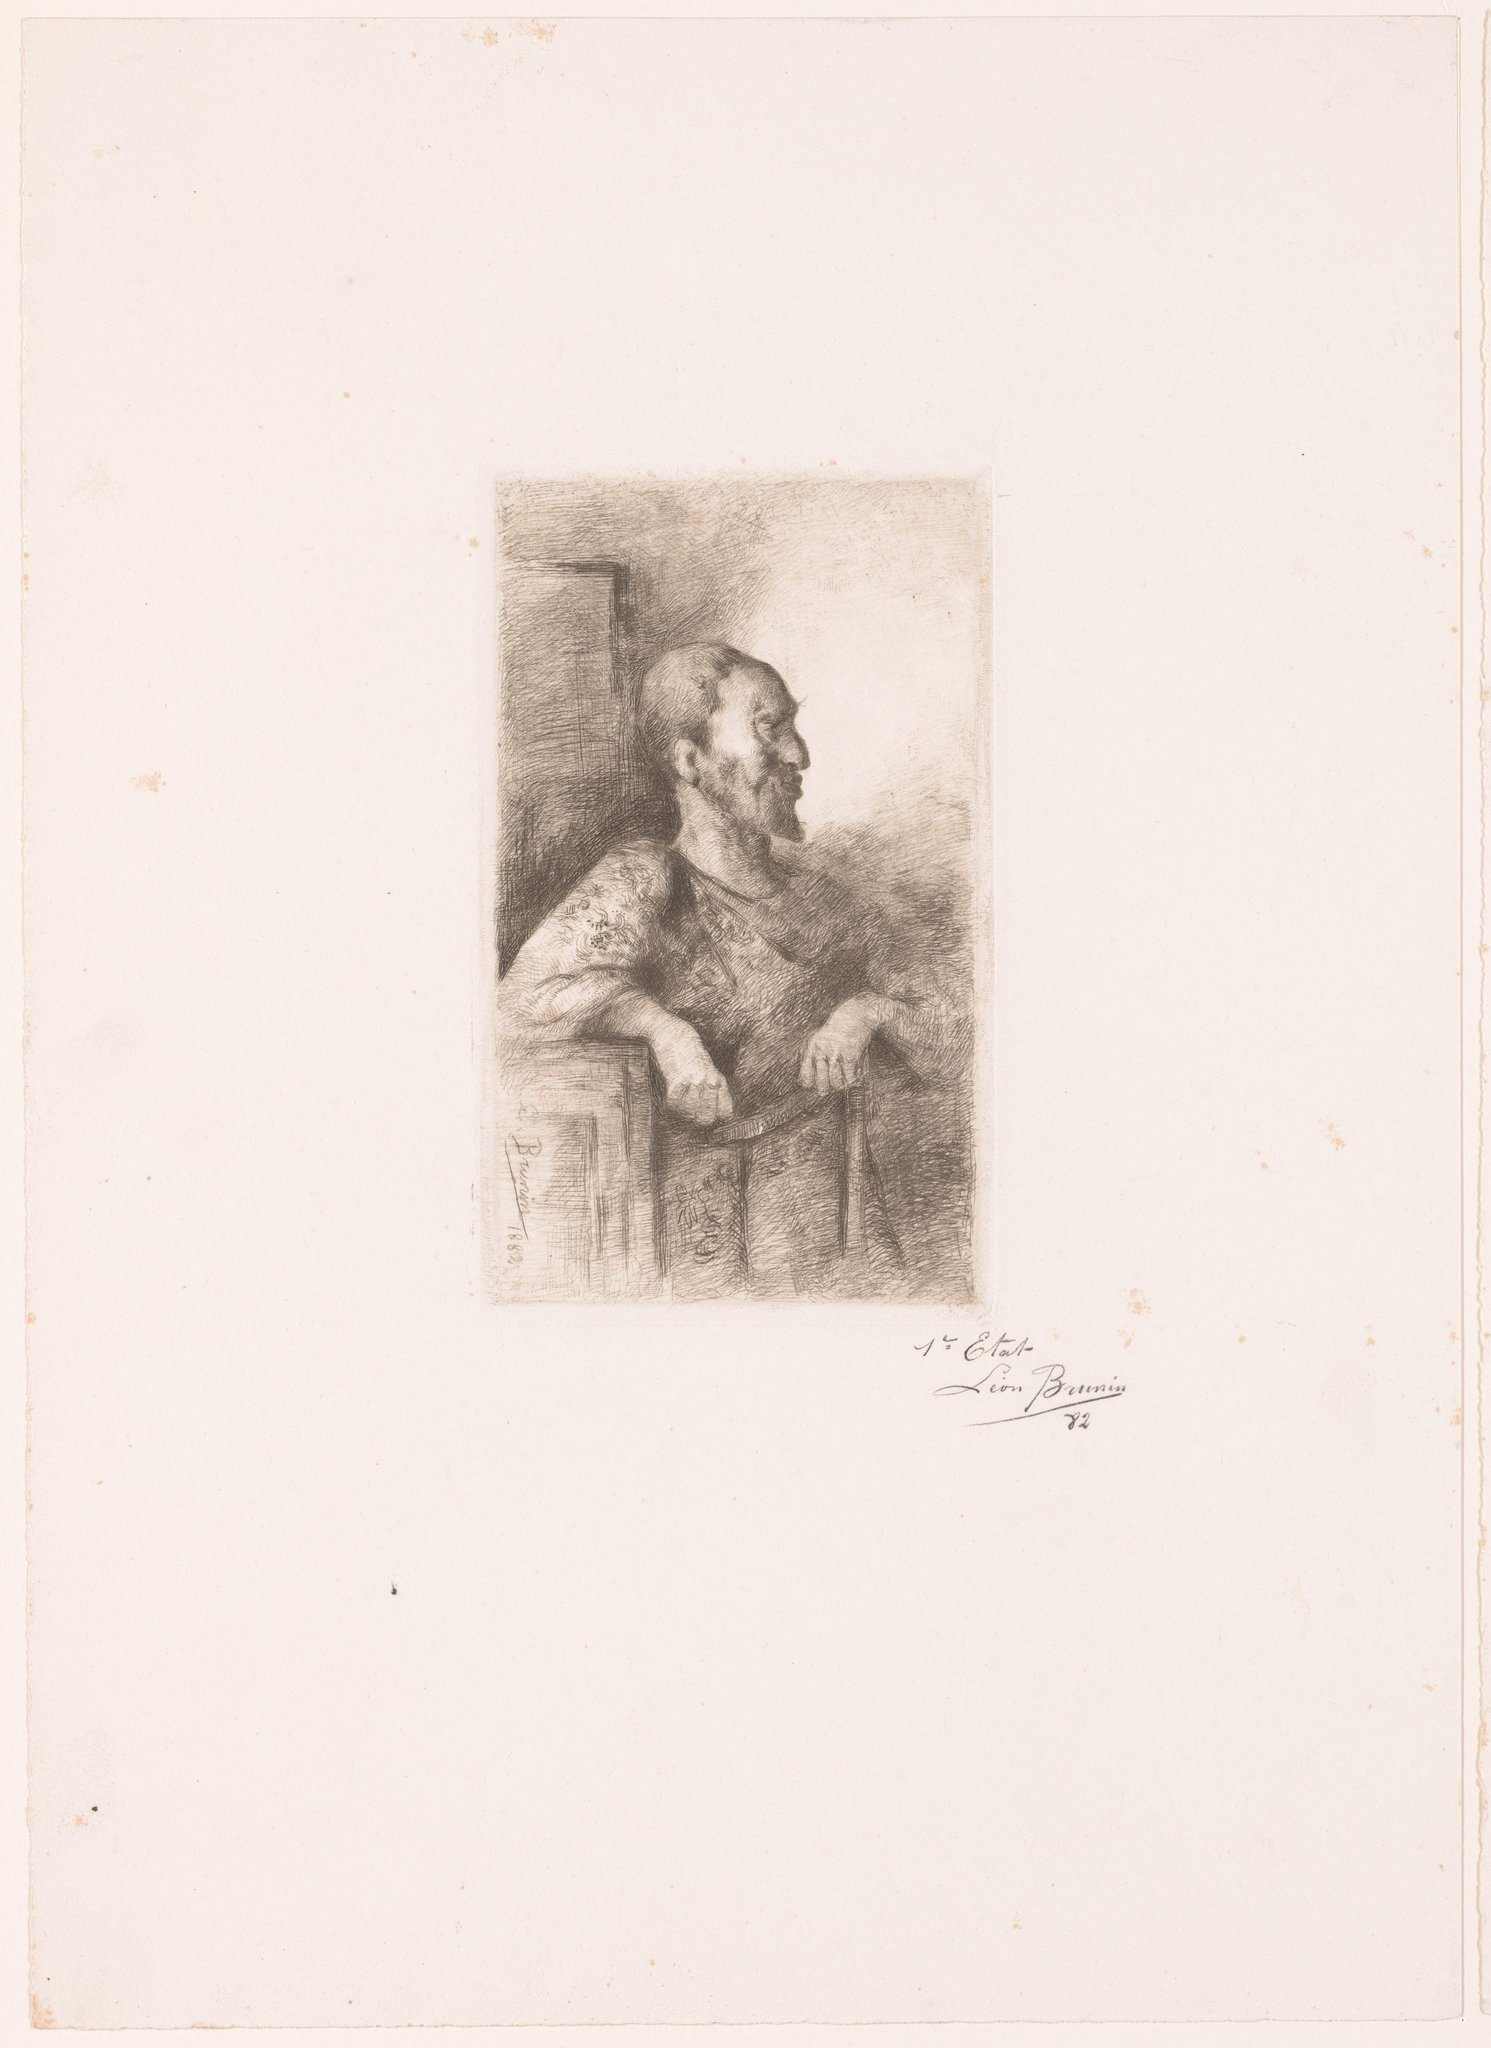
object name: print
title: Portret van een onbekende bebaarde man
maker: léon brunin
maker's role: print maker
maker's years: 1861-1949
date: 1882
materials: paper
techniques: etching, intaglio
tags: anonymous historical person portrayed alone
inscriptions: annotation: ‘1e Etat’, collector's mark: Lugt 2228